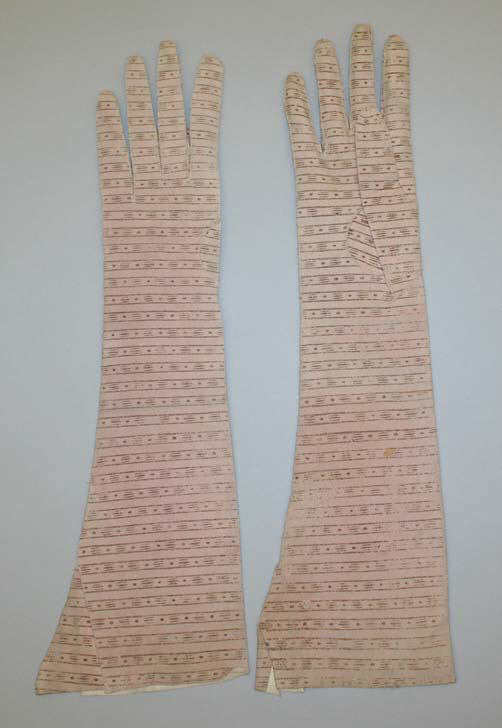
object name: glove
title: Gloves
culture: italian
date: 1767-1833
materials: leather